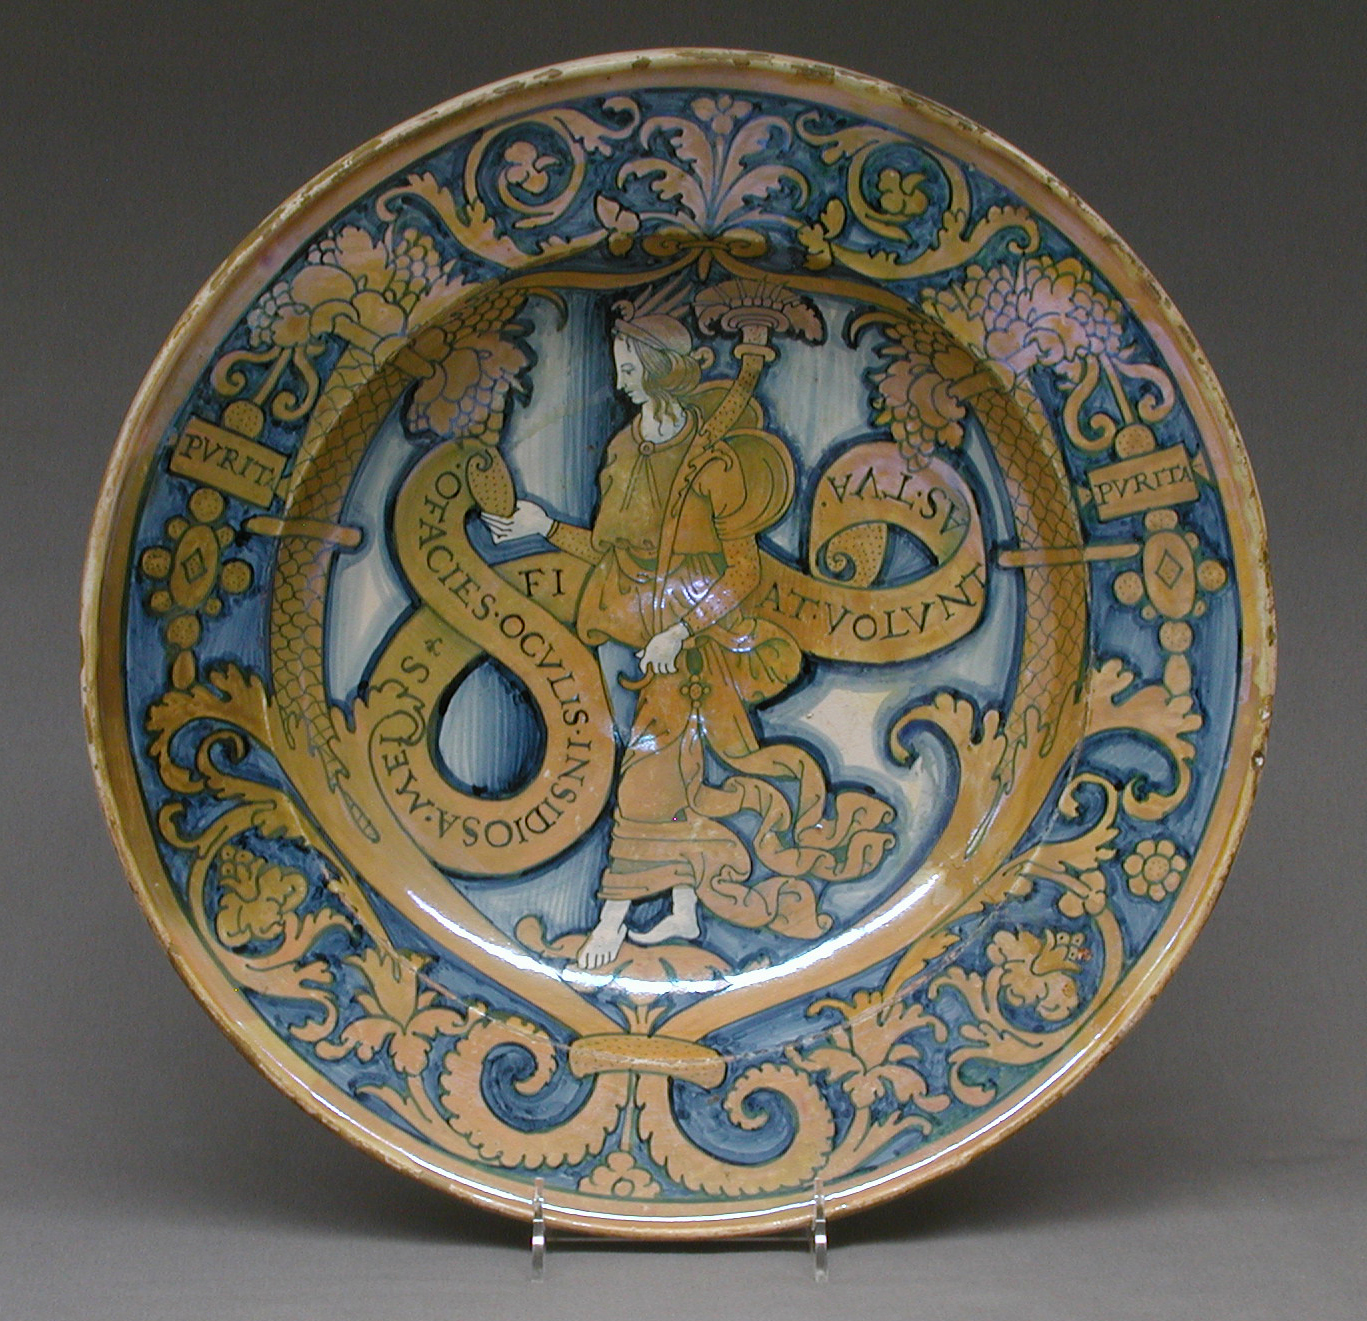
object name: plate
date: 1520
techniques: maiolica, glazing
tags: human figures